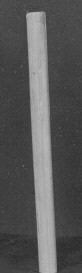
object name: wind instrument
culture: philippine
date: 1867-1900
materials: bamboo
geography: philippines